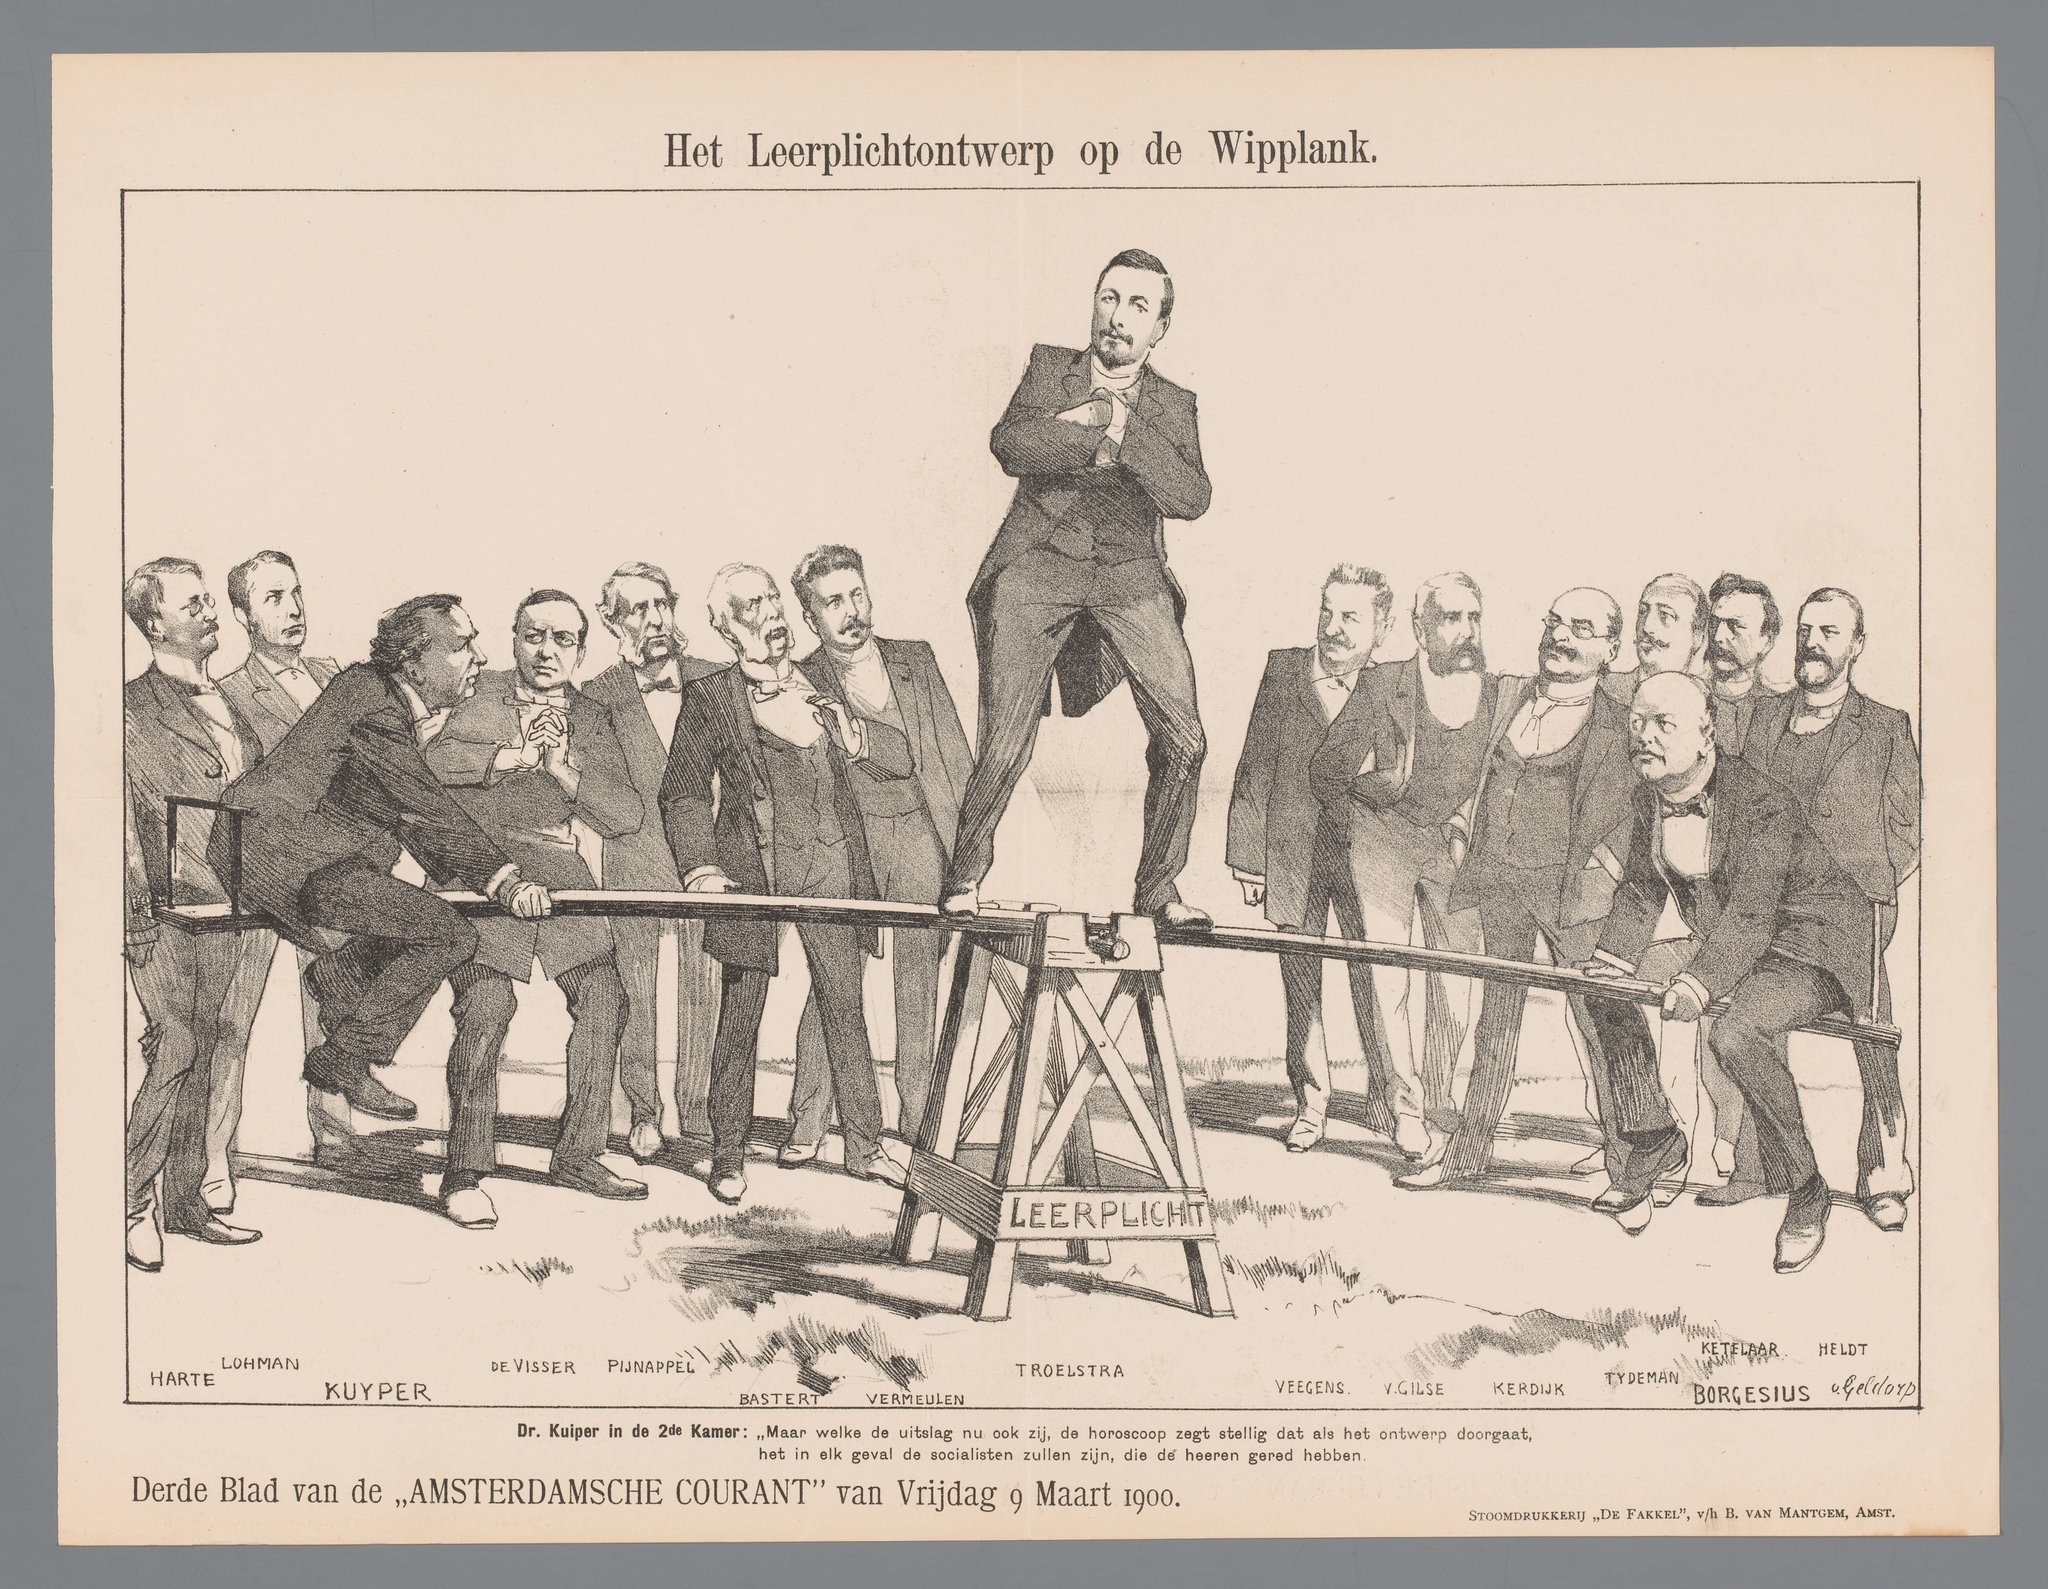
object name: cartoon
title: Het Leerplichtontwerp op de Wipplank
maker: petrus van geldorp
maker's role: draughtsman, print maker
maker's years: 1872-1939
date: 1900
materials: paper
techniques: lithograph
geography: amsterdam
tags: the hague, abraham kuyper, amsterdam, arnhem, politician, historical persons, politician, e.g. party leader, scholastic education, tuition, political caricatures and satires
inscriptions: date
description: Prent uit het bijvoegsel van: De Amsterdamsche Courant, 9 maart 1900.